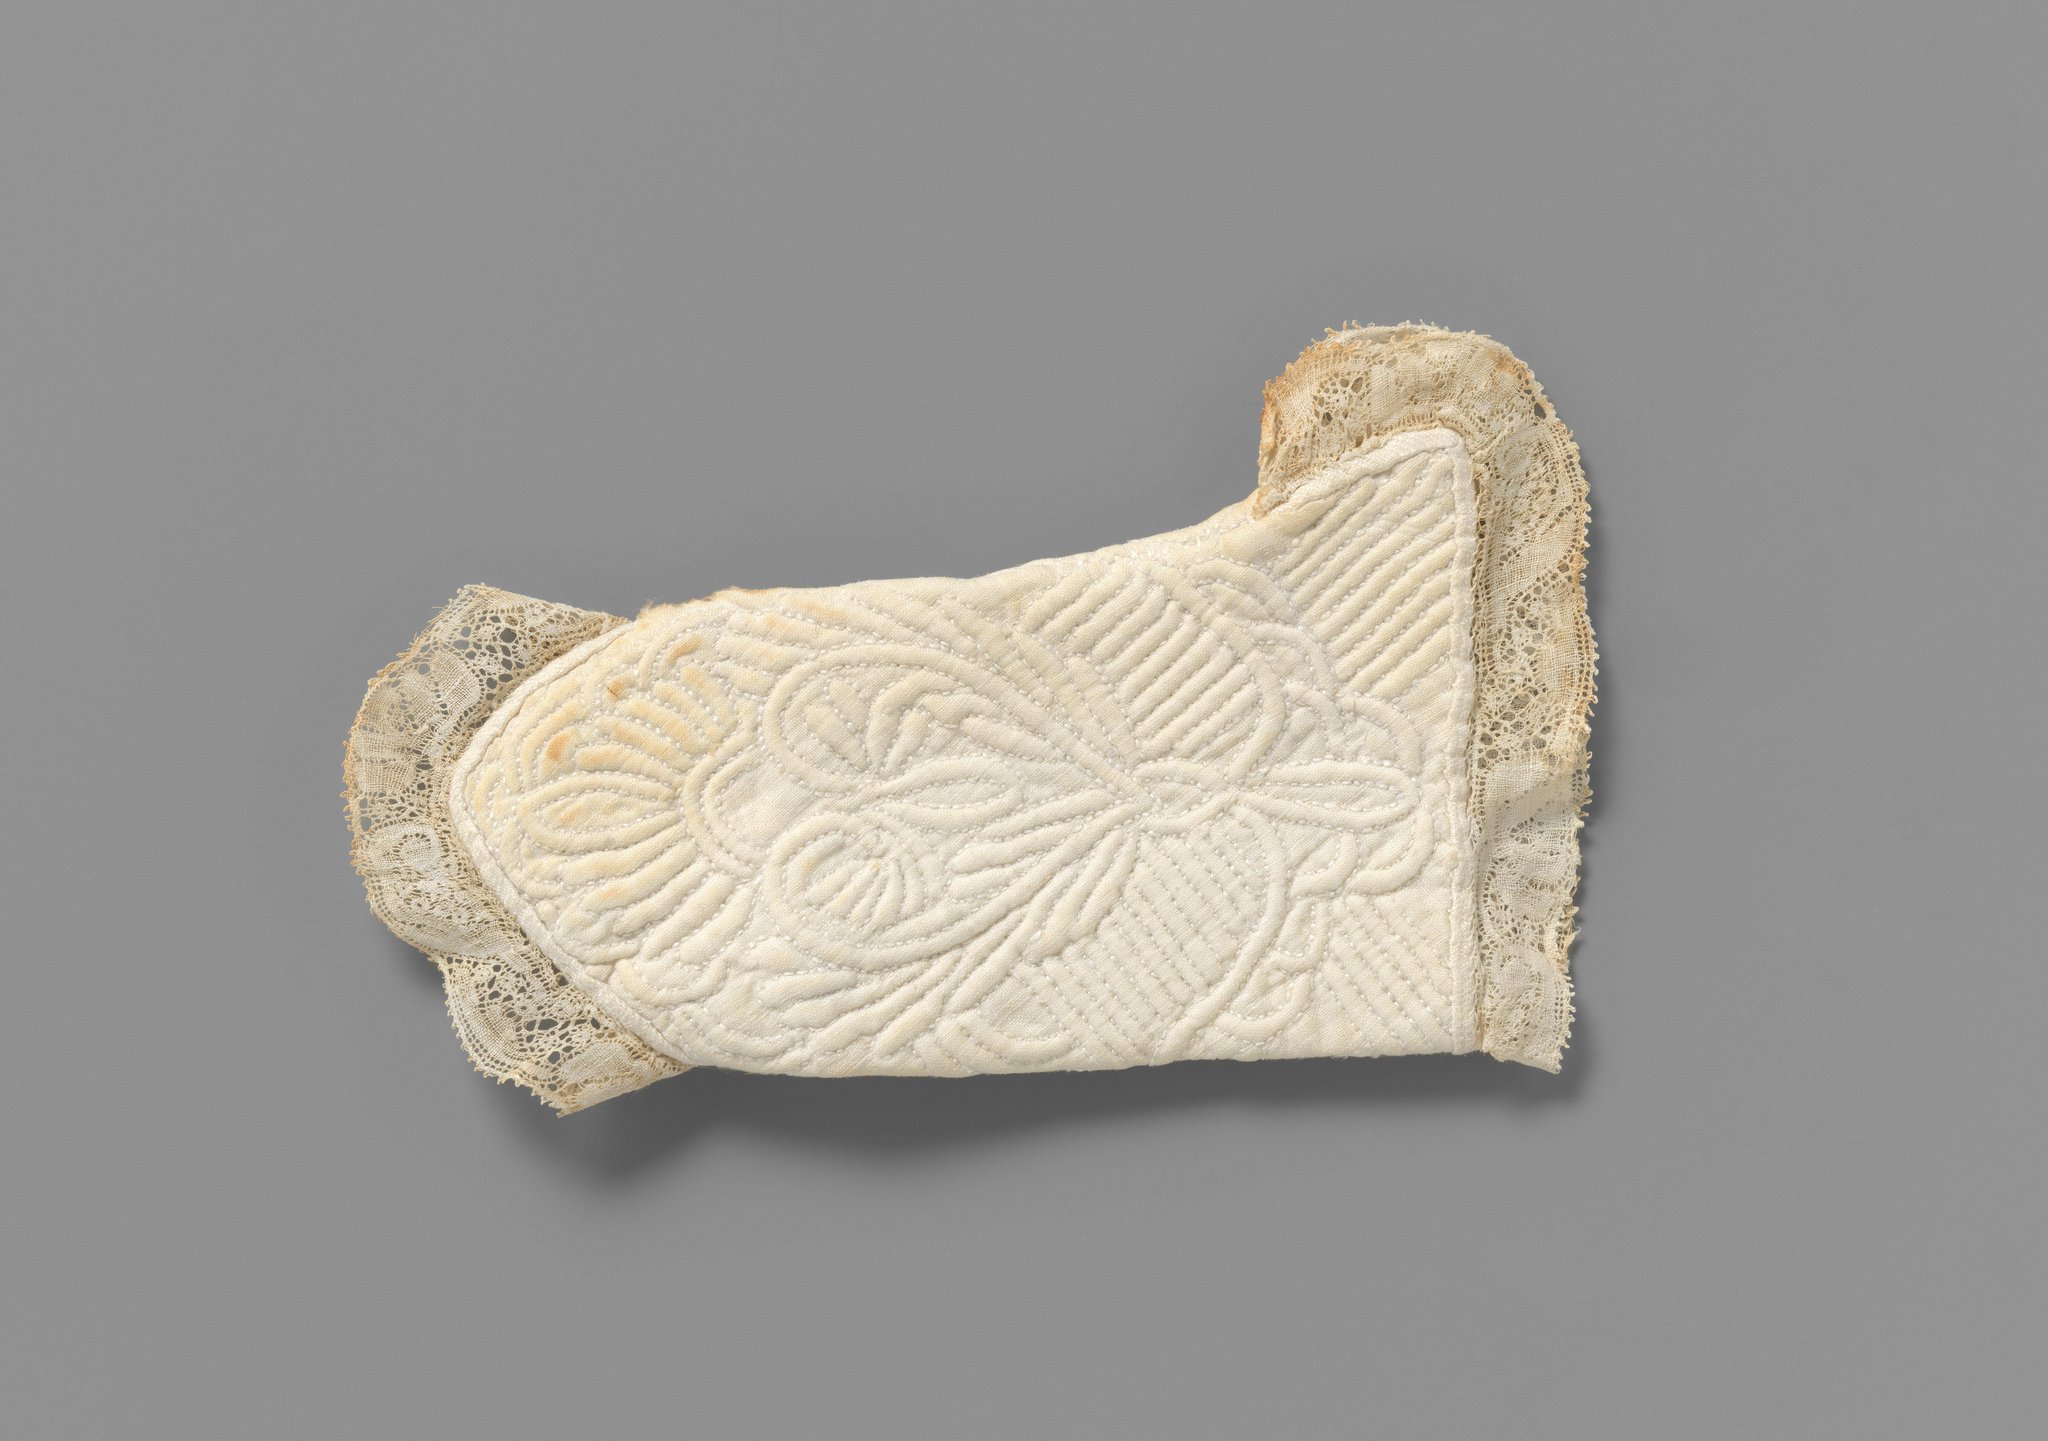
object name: childrenswear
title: Mitaine van wit katoen met Zaans stikwerk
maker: Anonymous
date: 1780-1820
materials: cotton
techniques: quilted embroidery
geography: netherlands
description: Mitaine van wit katoen met Zaans stikwerk, afgezet met kant, voor baby of kind.